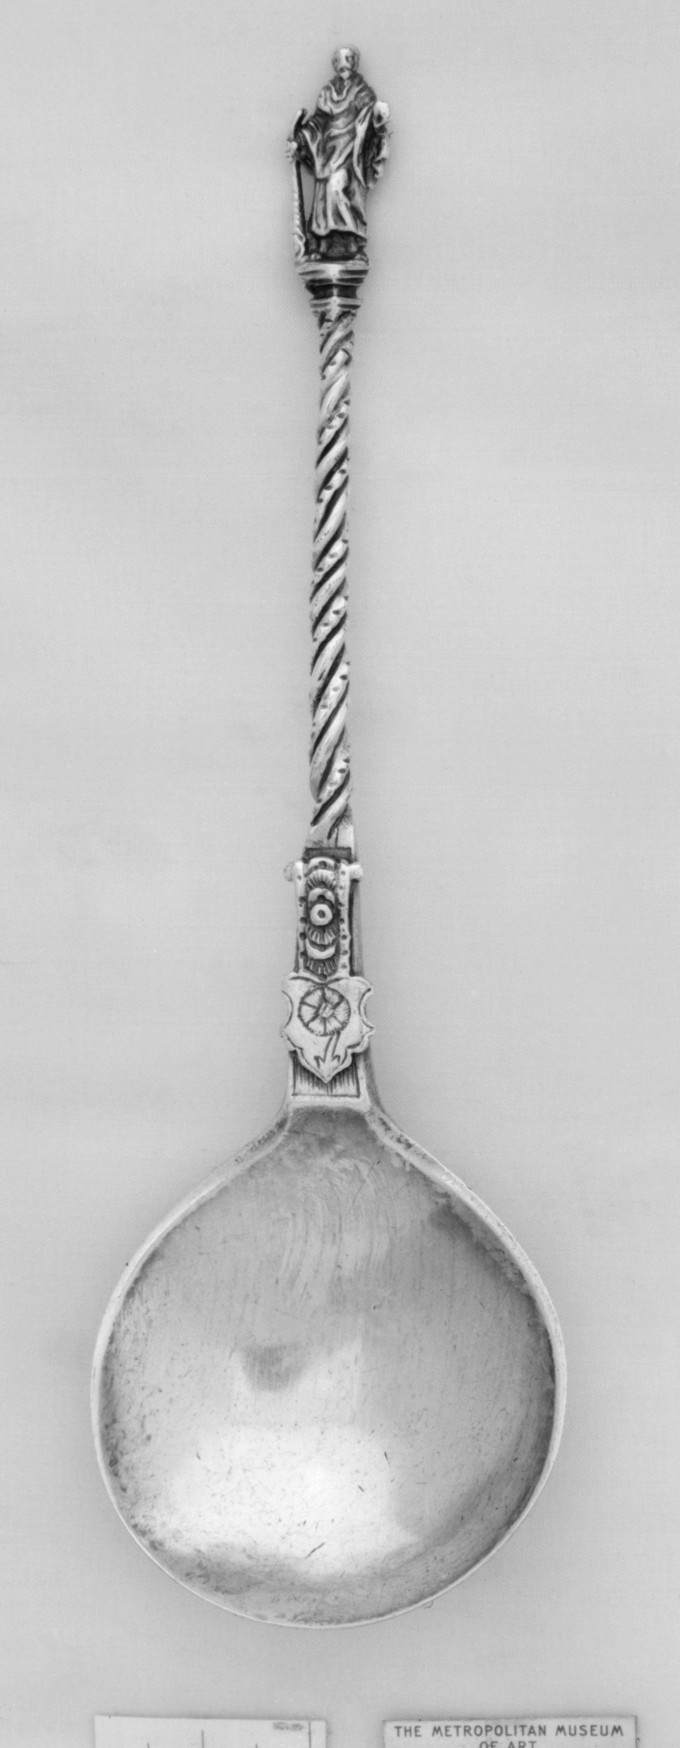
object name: apostle spoon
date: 1619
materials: gilt, silver